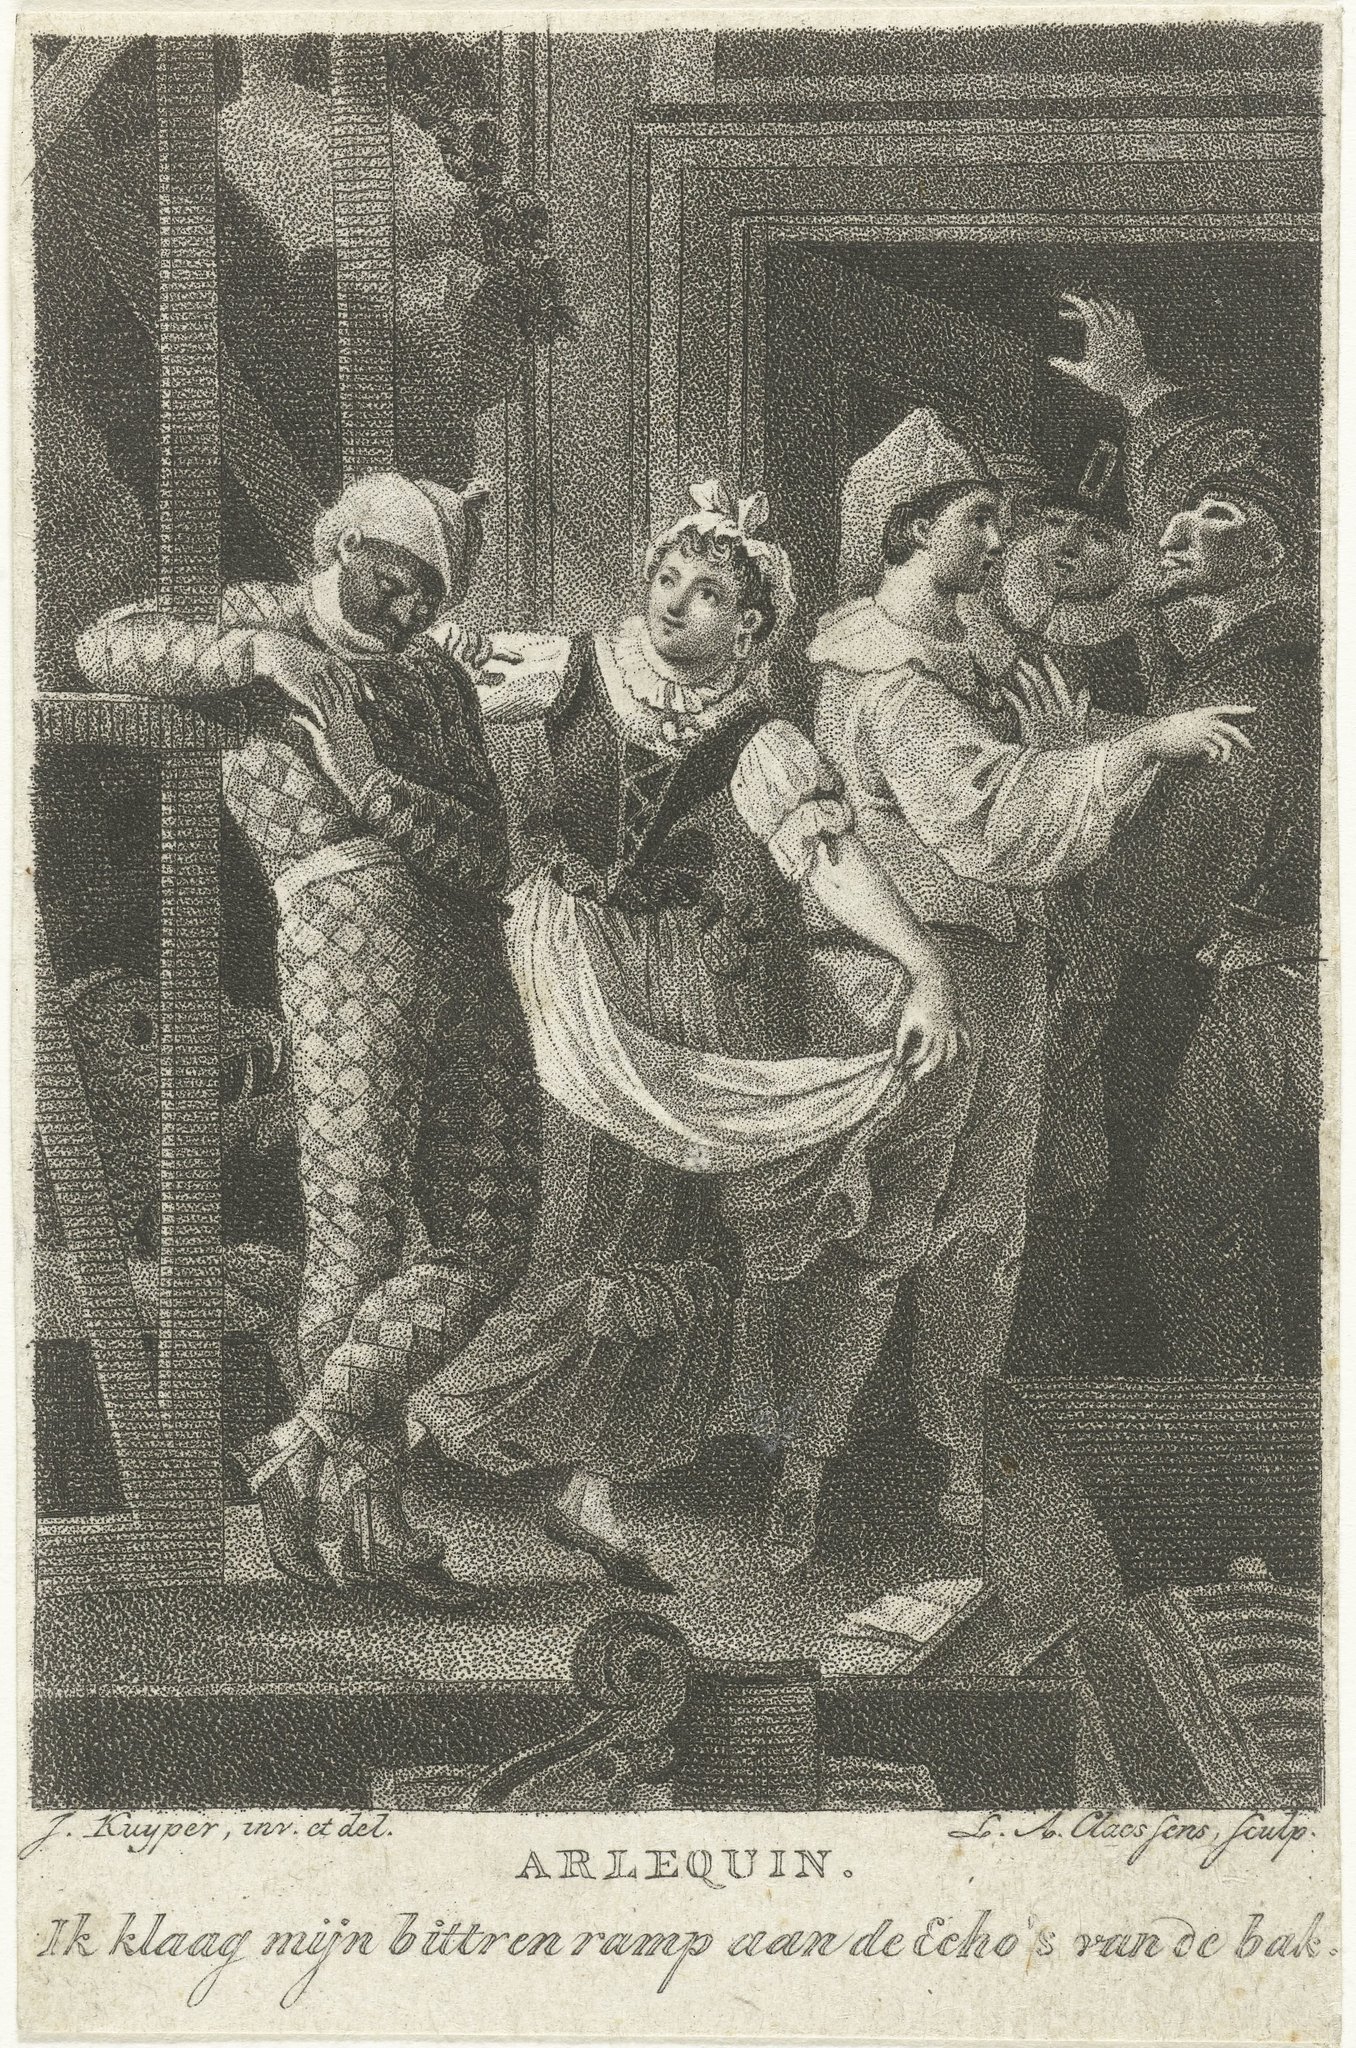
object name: book illustration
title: Harlekijn op het toneel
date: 1801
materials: paper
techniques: etching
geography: netherlands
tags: behind the stage, types in 'commedia dell'arte': harlequin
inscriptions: collector's mark: Lugt 2228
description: Een Harlekijn staat op het toneel, dichtbij de orkestbak. Hij kijkt een beetje sip en een meisje probeert hem op te vrolijken. In een deuropening staan nog andere toneelfiguren.